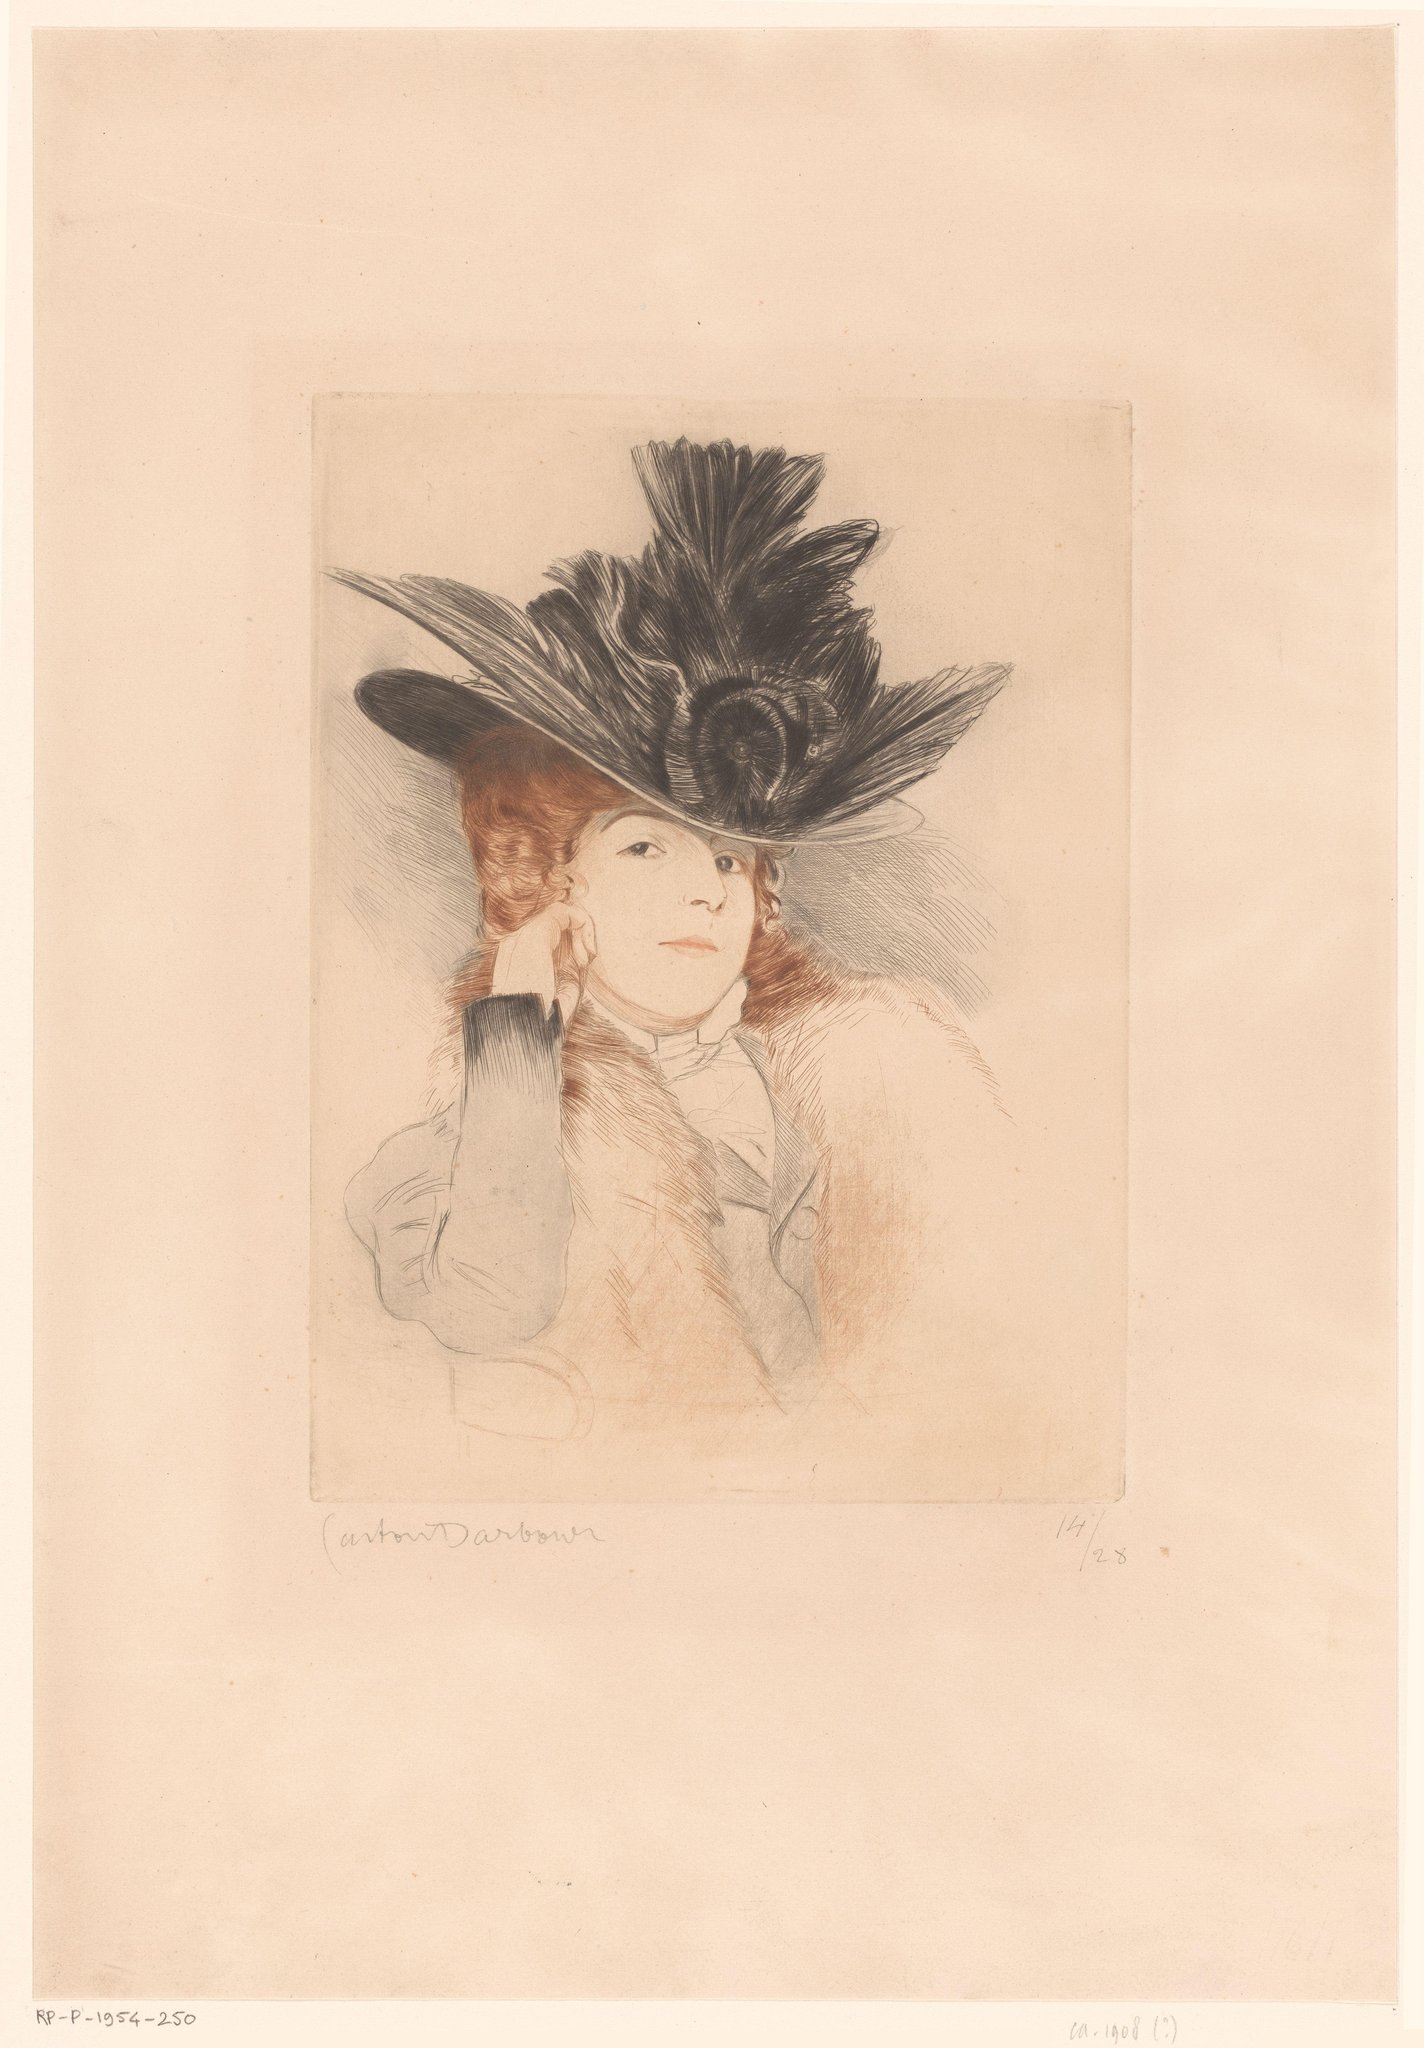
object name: print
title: Portret van een onbekende dame met hoed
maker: gaston darbour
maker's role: print maker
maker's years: 1869-1920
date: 1879-1920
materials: paper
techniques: drypoint, etching, intaglio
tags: head-gear: hat (+ women's clothes)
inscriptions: collector's mark: Lugt 2760, collector's mark: Lugt 2228